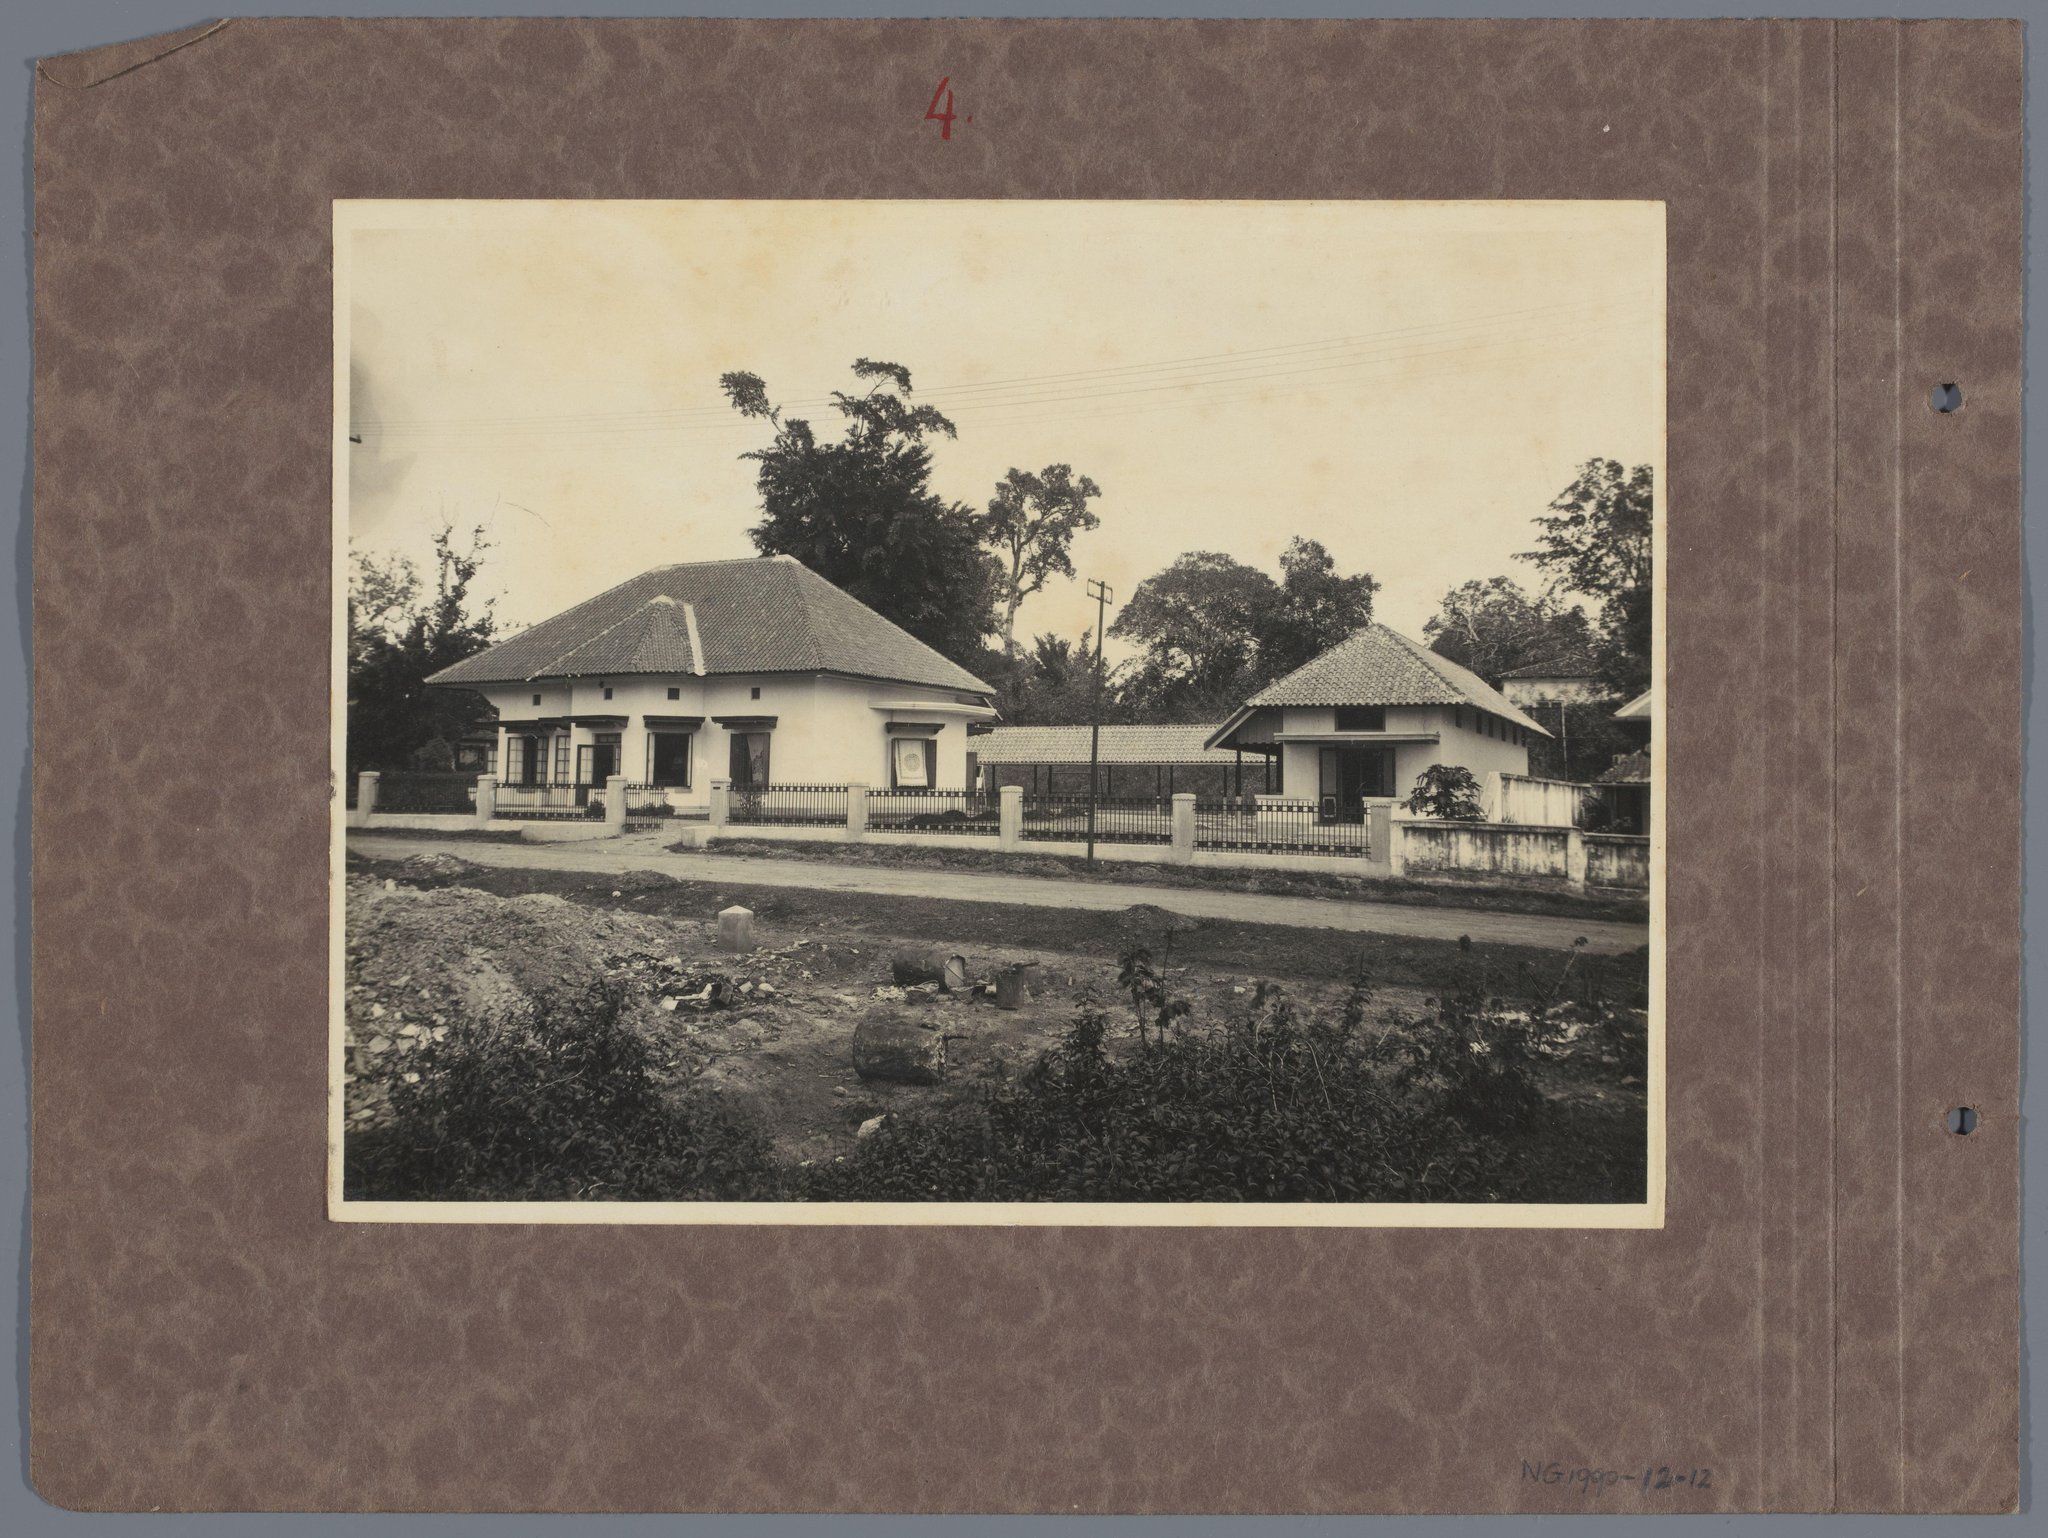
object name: photograph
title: Woonhuis met hek en tuin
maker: Anonymous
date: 1900-1940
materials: cardboard, photographic support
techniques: gelatin silver print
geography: sumatra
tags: sumatra, dutch east indies, the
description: Gezicht op een woonhuis met hek en tuin. Foto opgeplakt op een albumblad genomen uit een fotoalbum. Onderdeel van een groep van 14 losse foto's genomen op Midden- en Zuid-Sumatra in de periode ca. 1900-1940.